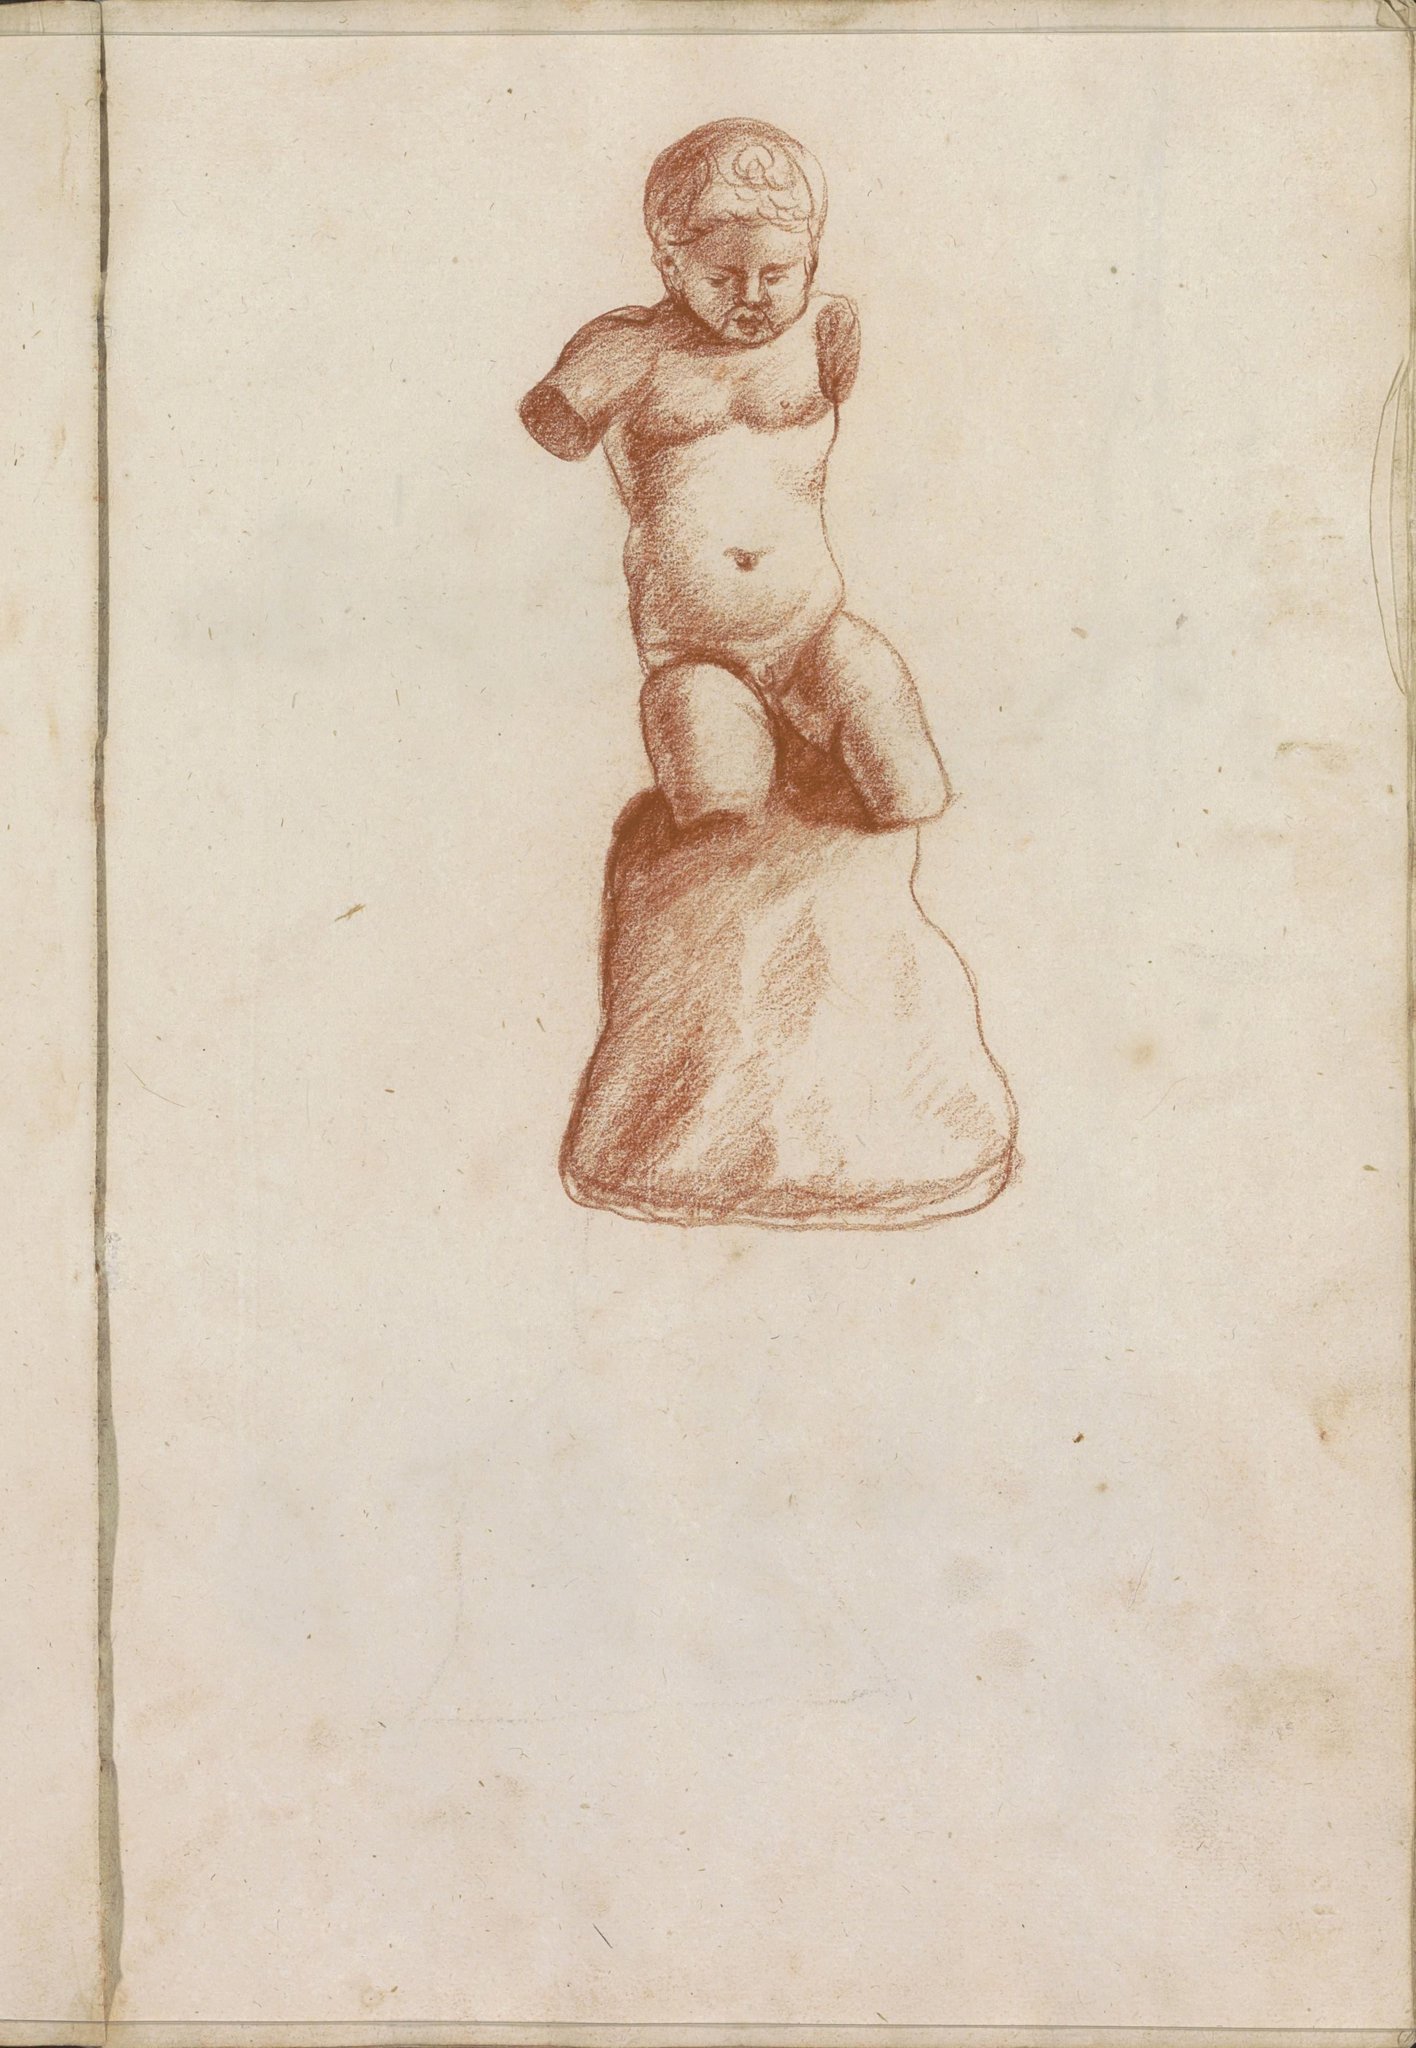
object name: sketchbook leaf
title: Sculptuur van een naakte jongen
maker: hendrick van beaumont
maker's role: draughtsman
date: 1696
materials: chalk, paper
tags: sculpture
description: Mogelijk getekend naar een prent. Blad 23 recto uit een schetsboek met 91 bladen.